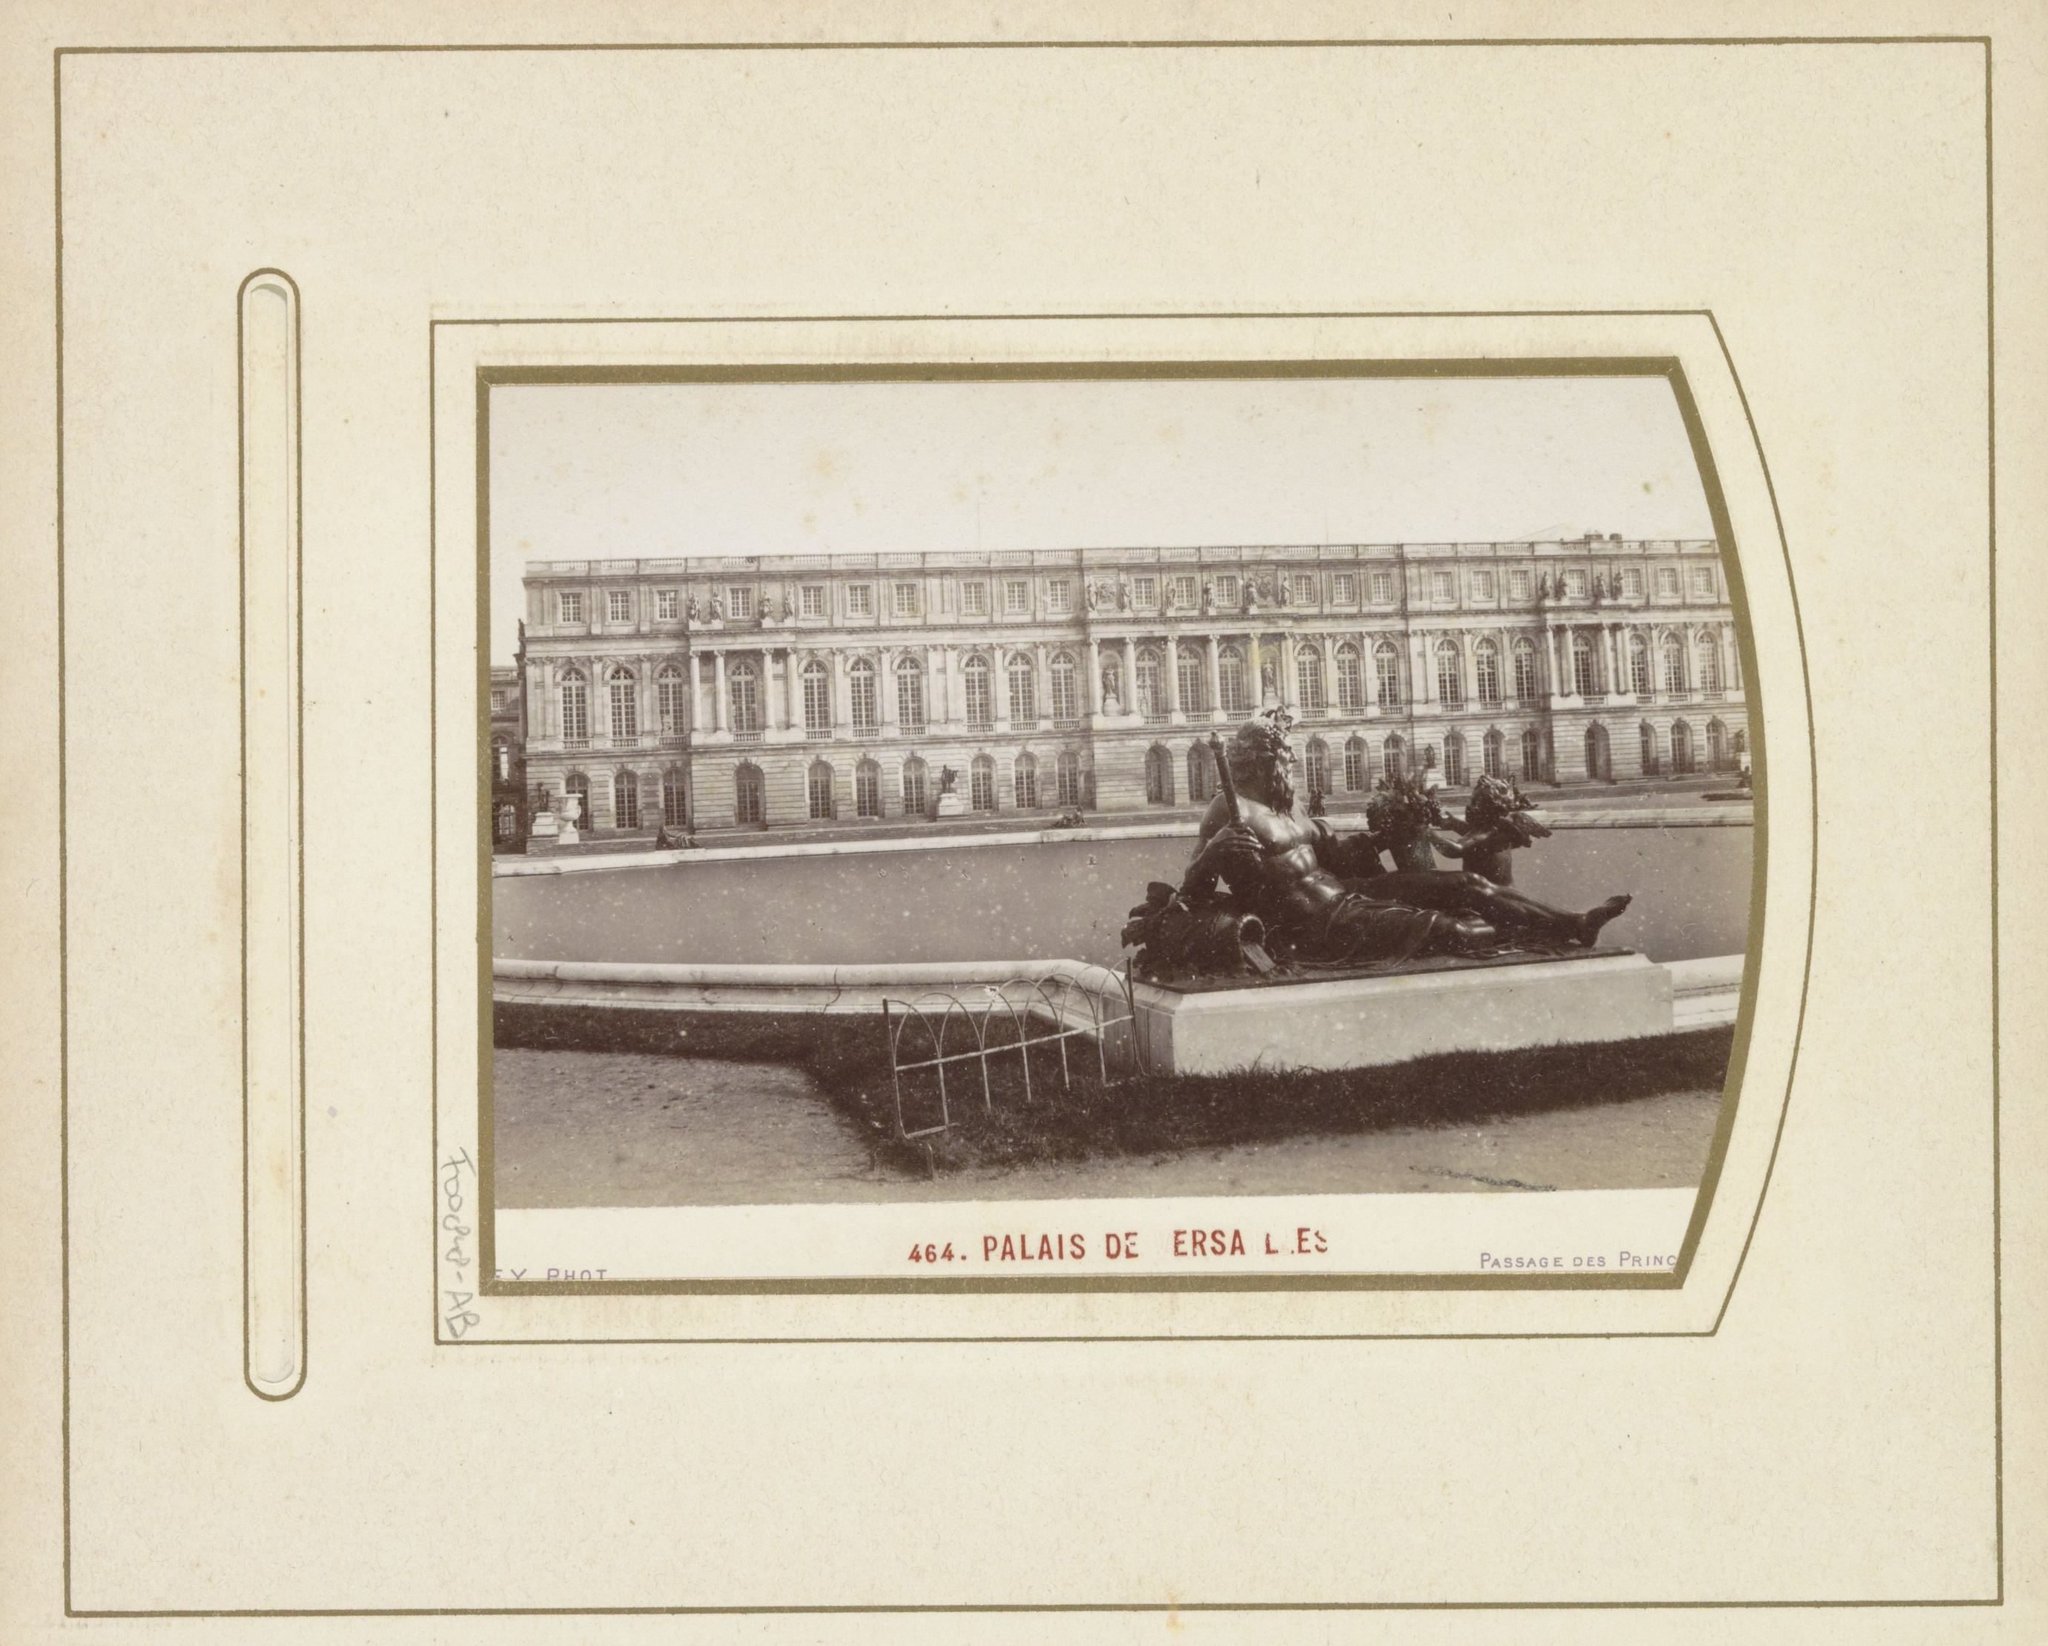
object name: cabinet photograph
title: Paleis van Versailles met op de voorgrond een vijver met beeld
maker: ernest ladrey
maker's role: fotograaf, illustrator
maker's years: 1830-1889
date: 1870-1900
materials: cardboard, paper, photographic support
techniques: albumen print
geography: versailles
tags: palace, piece of sculpture, reproduction of a piece of sculpture, pond, pool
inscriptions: inscription: ‘Maison Martinet Albert Hautecoeur 12, Bd des Capucines’, address: ‘Passage des Princes PARIS.’, number: ‘464.’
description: Onderdeel van Fotoalbum met kabinetfoto's van bezienswaardigheden in Parijs en Versailles.